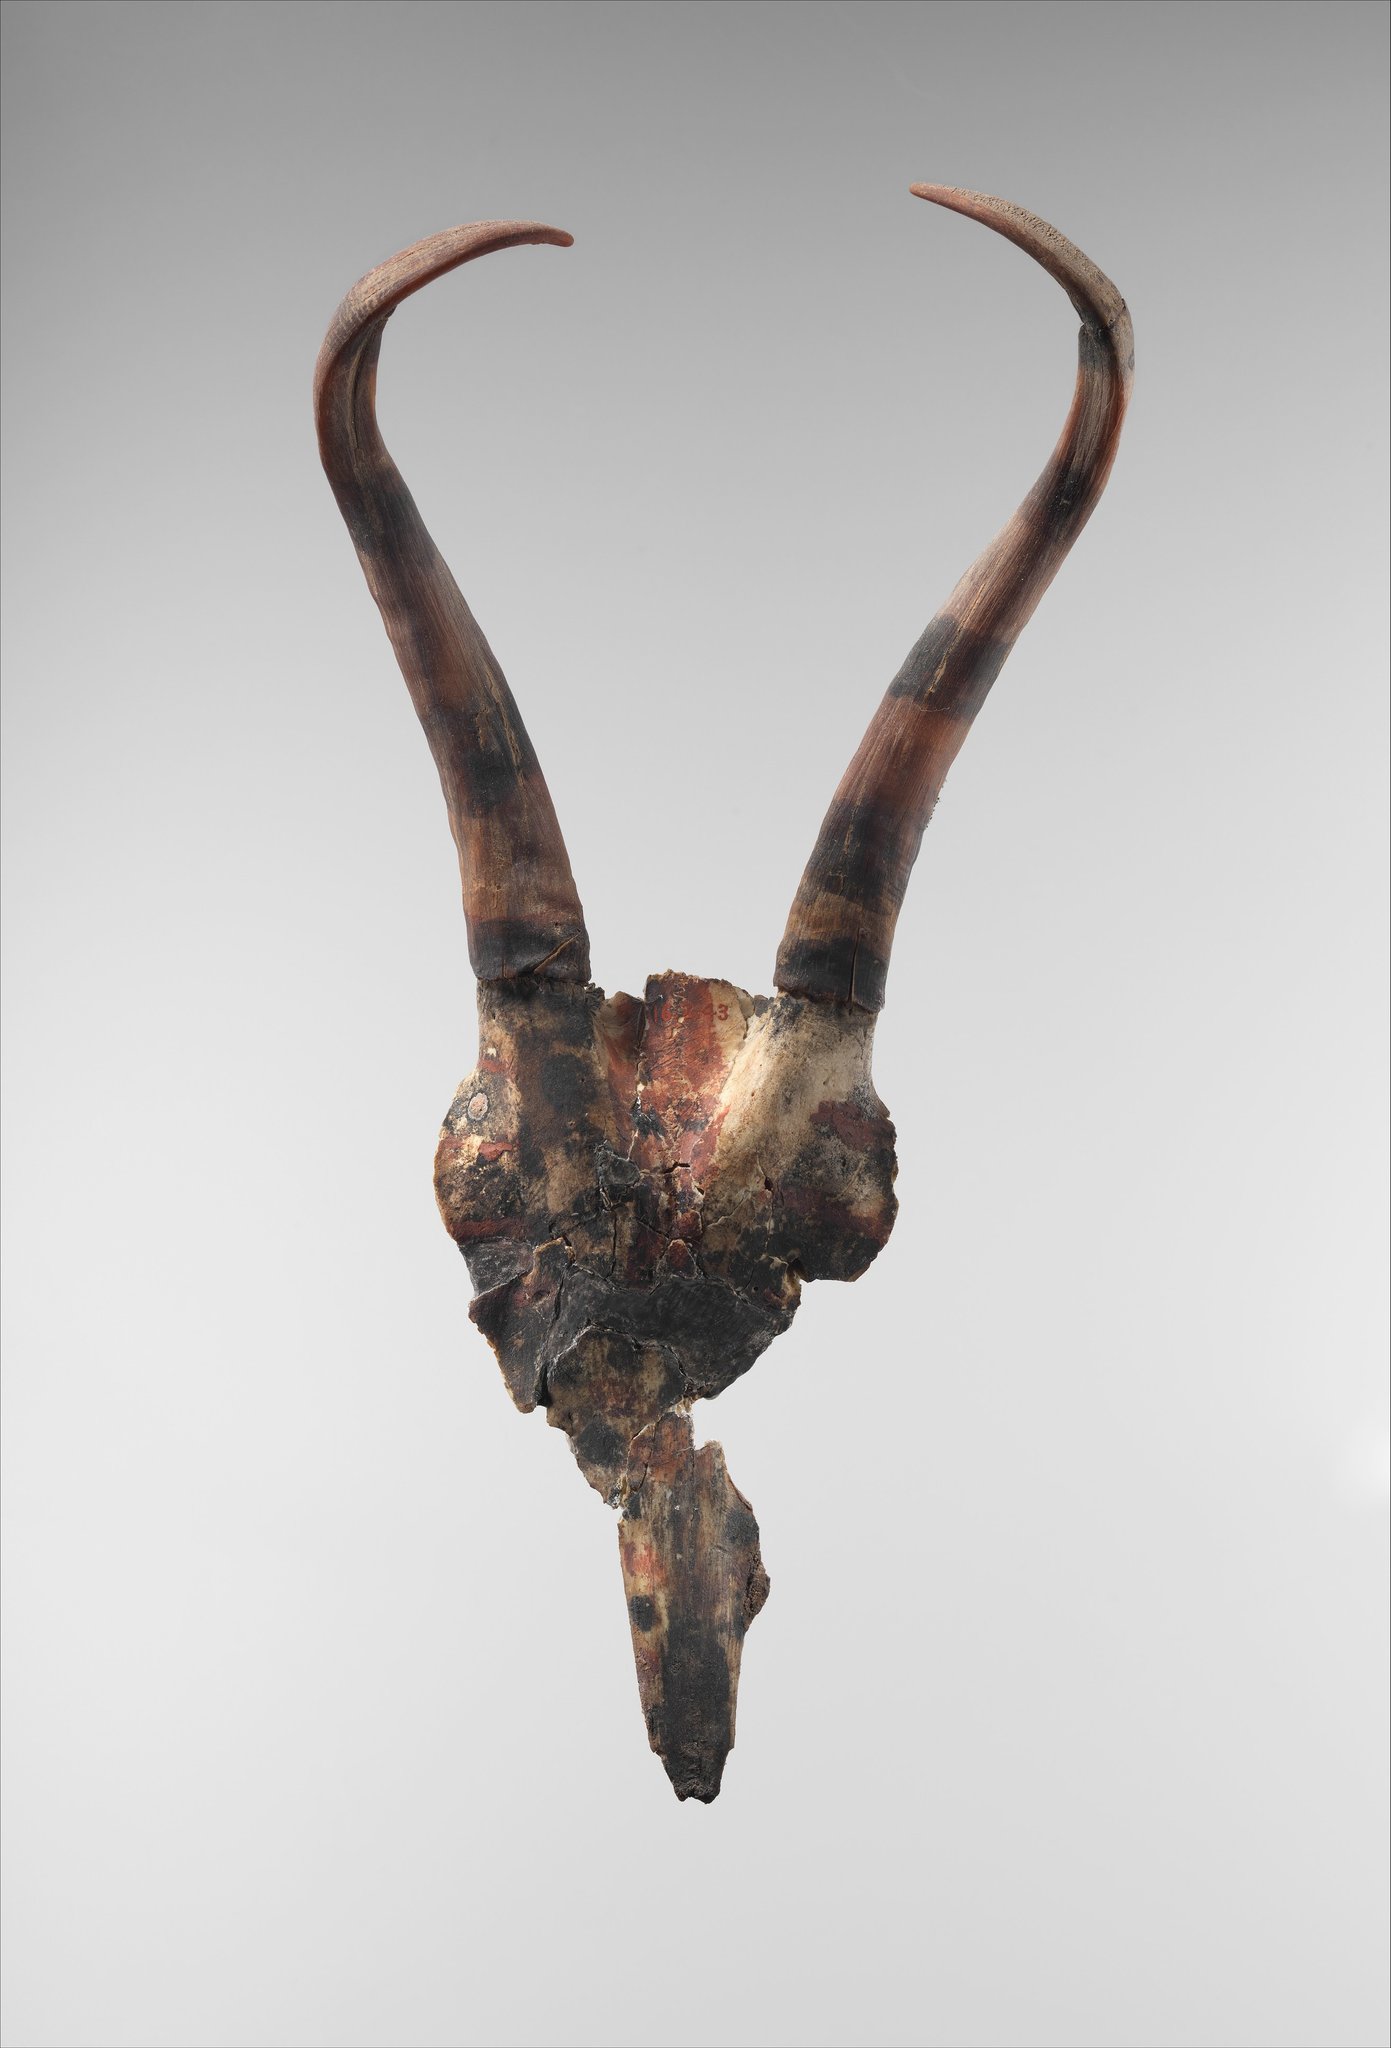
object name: bucranium, antler, horn, pan grave, medjayu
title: Bucranium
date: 1640-1550 BCE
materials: antler, bone, paint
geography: egypt and sudan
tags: animals,skulls